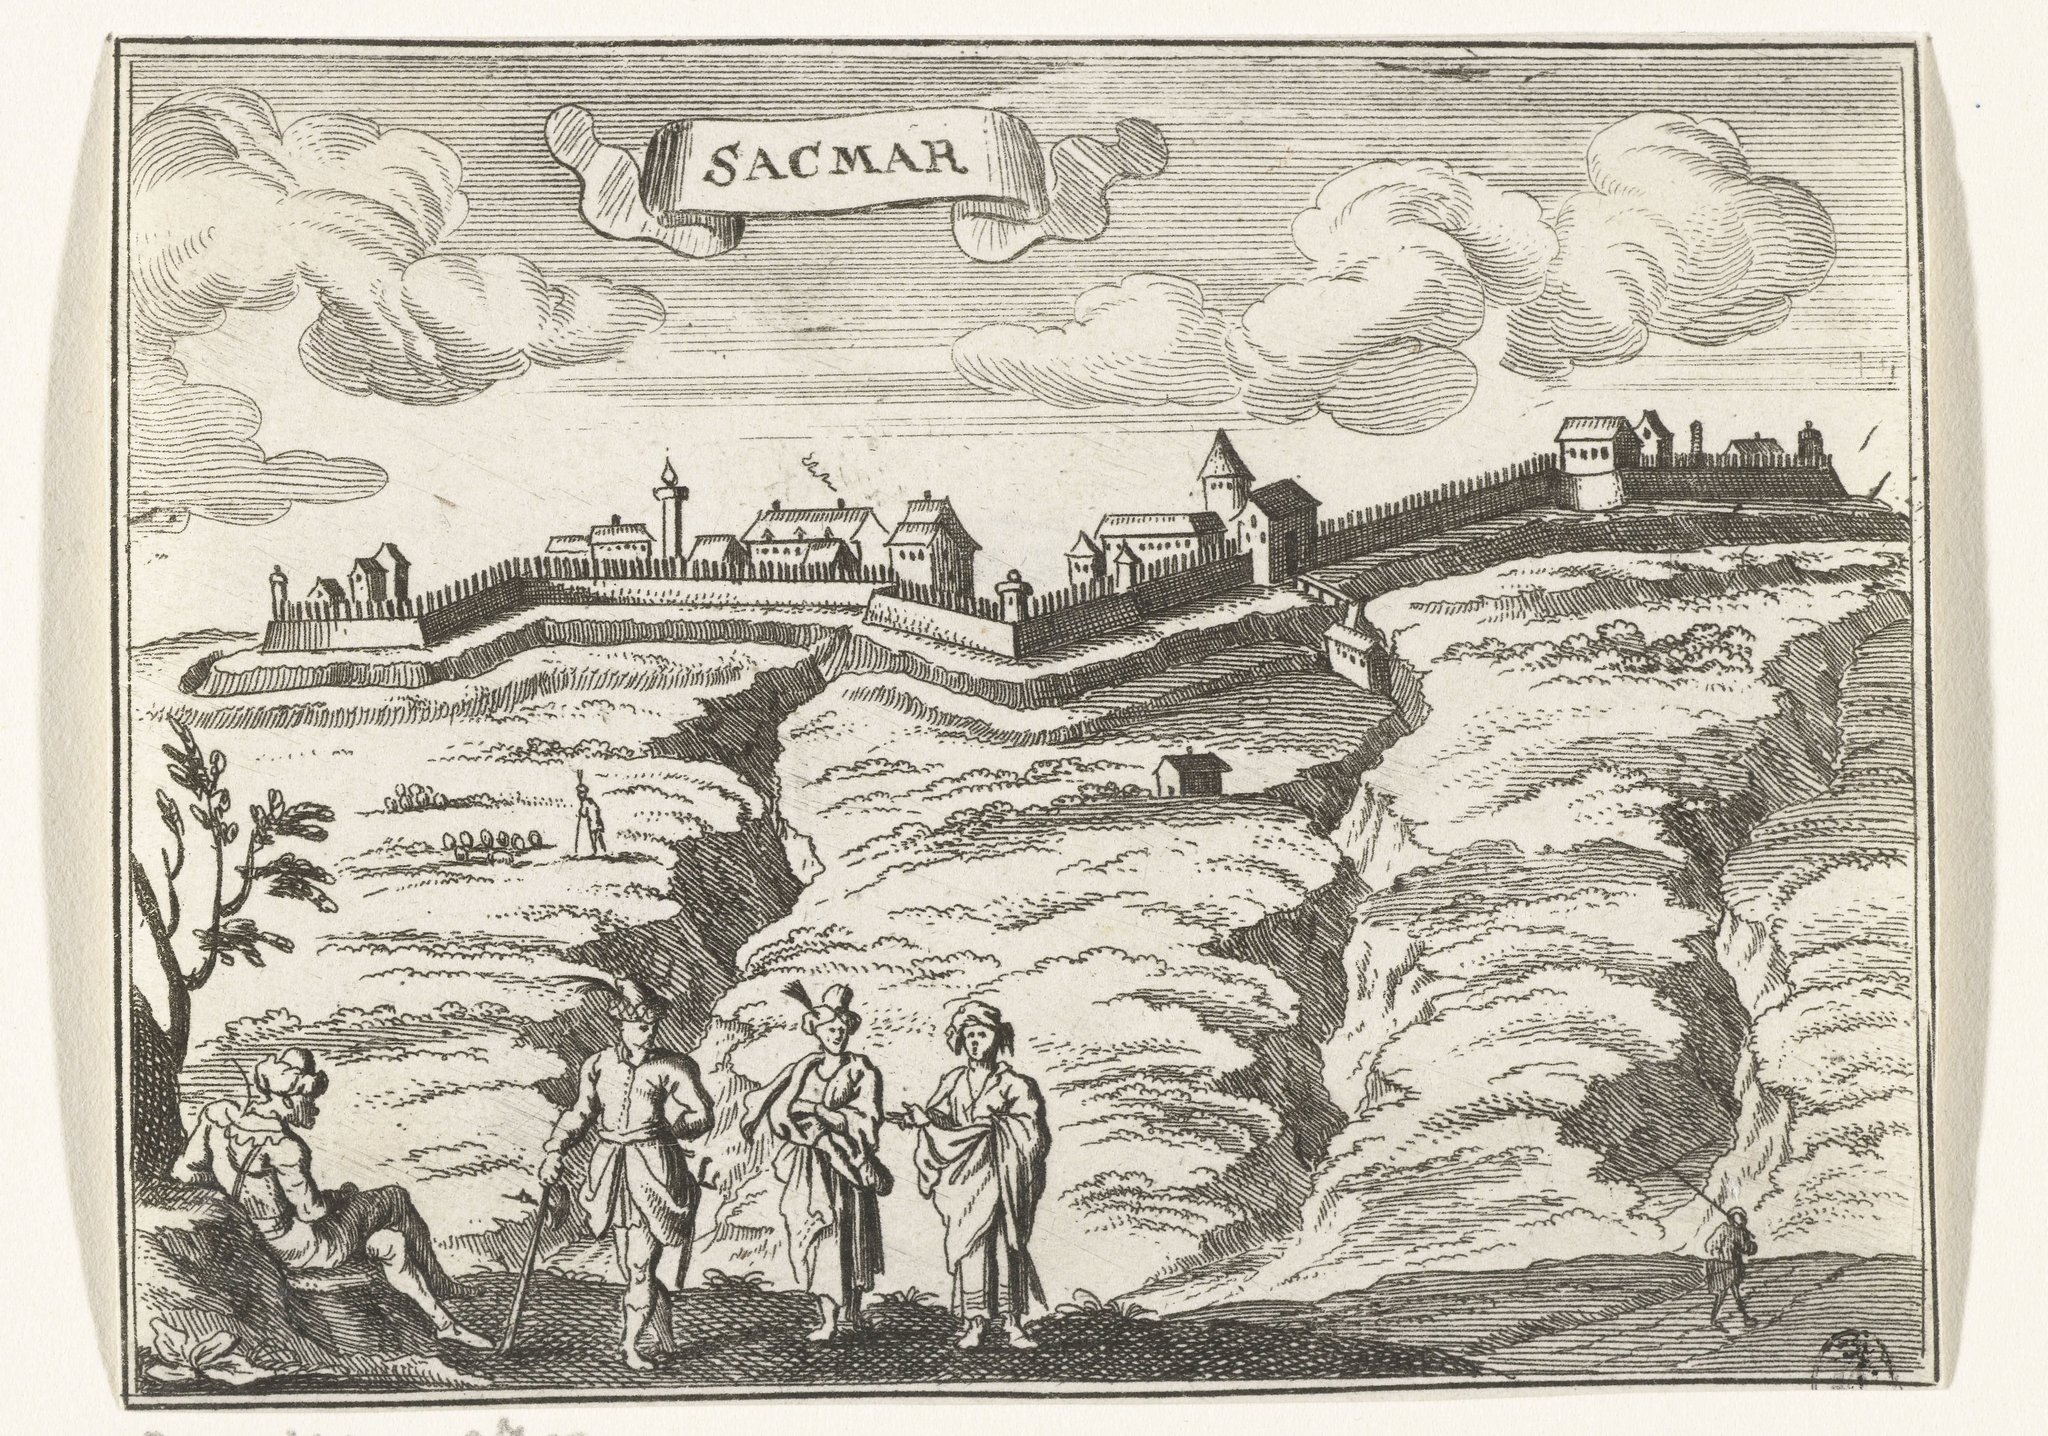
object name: print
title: Gezicht op Satu Mare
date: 1686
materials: paper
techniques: etching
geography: antwerp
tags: prospect of city, town panorama, silhouette of city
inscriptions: collector's mark: Lugt 2760, collector's mark: Lugt 2228, collector's mark: Lugt 971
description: illustriatie voor J. Peeters en C. Bouttats, "Korte beschryvinghe, en de aen-wysinghe der plaetsen in desen boeck, met hunnen teghen woordighen standt, pertinentelijk uyt-ghebeldt, in Oostenryck", Antwerpen 1686.